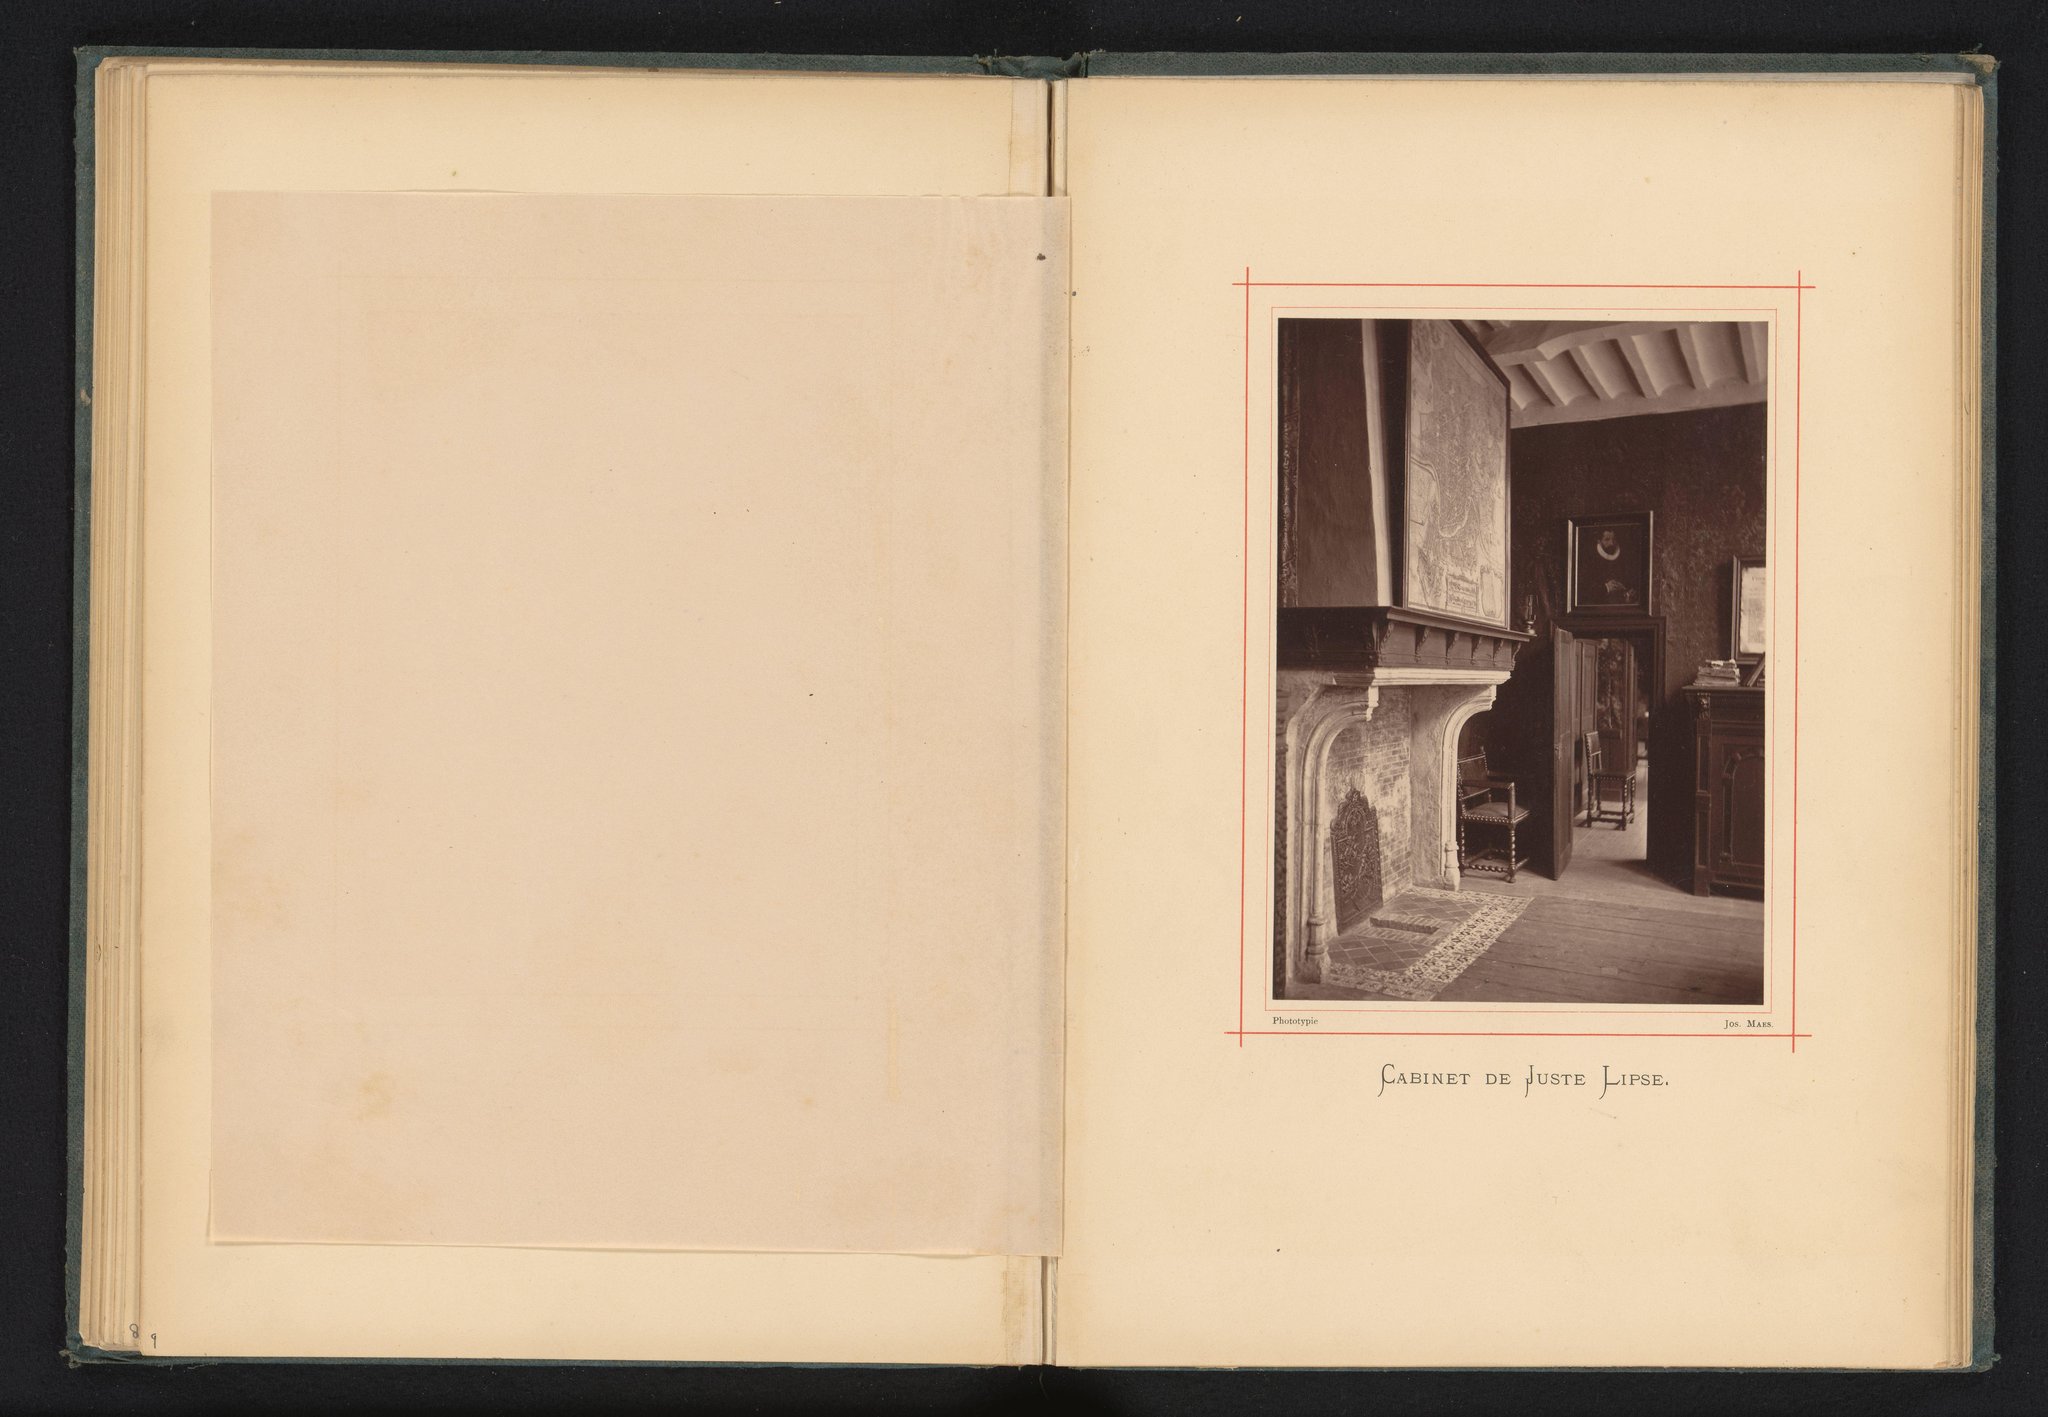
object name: page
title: Interieur van het huis van Christoffel Plantijn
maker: joseph maes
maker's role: fotograaf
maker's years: 1838-1908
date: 1873-1878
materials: paper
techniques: woodburytype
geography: antwerp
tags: interior of the house